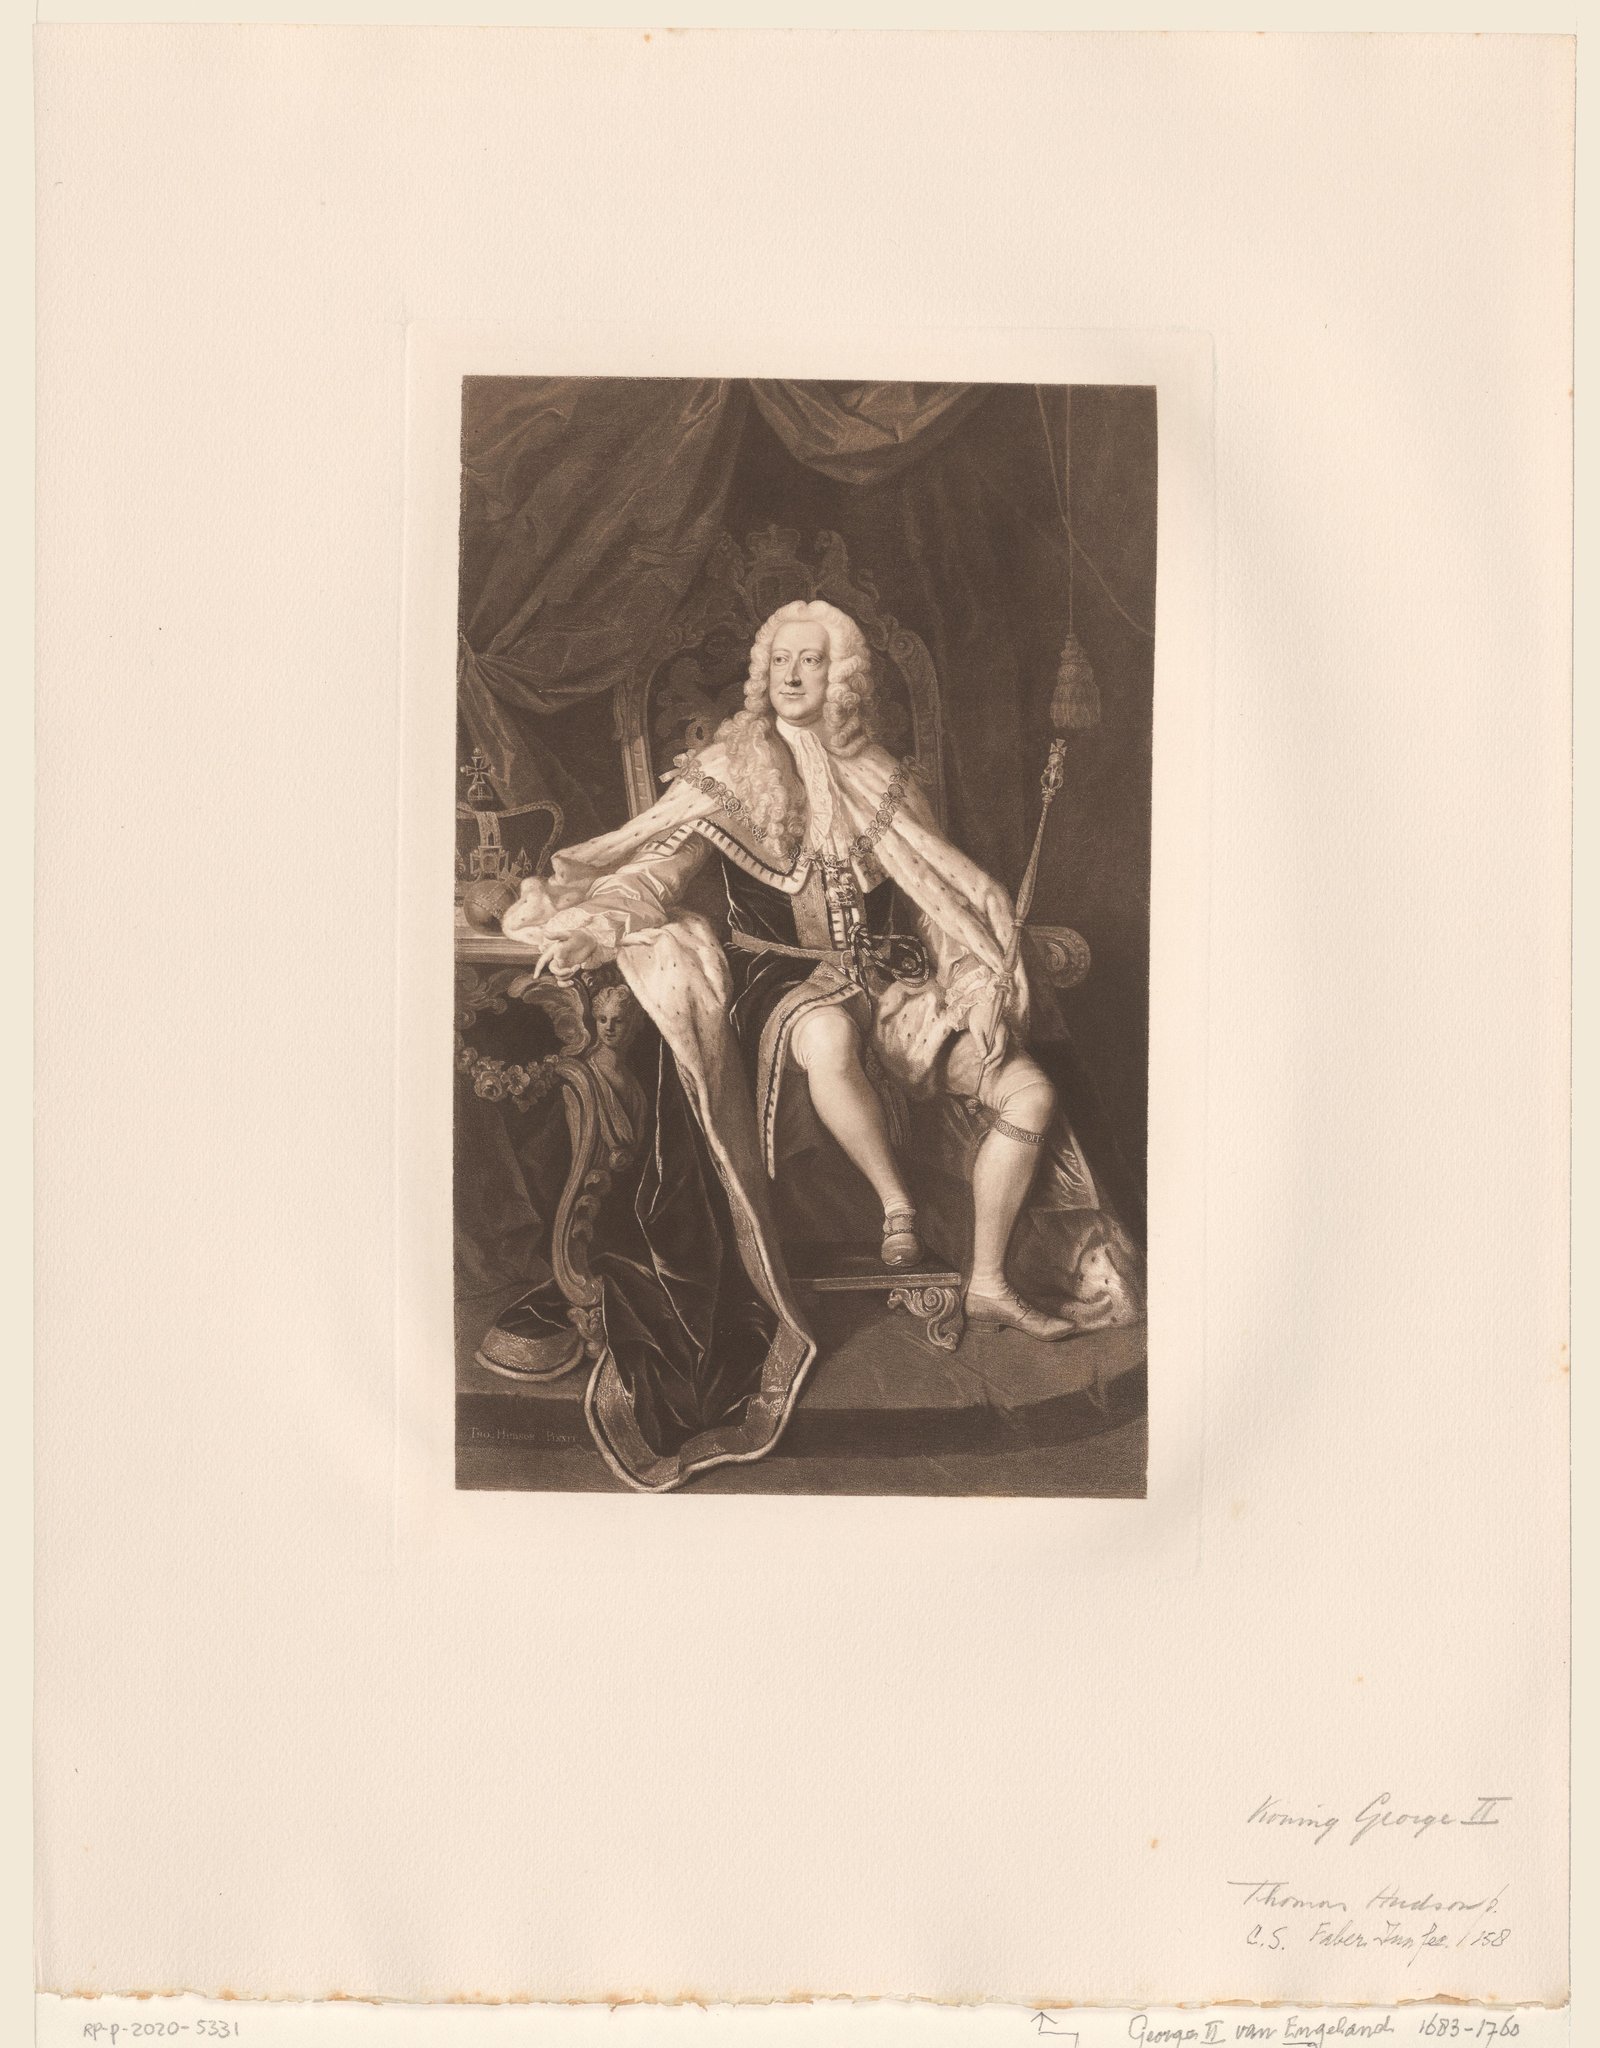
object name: photomechanical print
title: Portret van George II, koning van Groot-Brittannië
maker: Anonymous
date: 1850-1920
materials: paper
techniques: photoaquatint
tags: historical persons, king